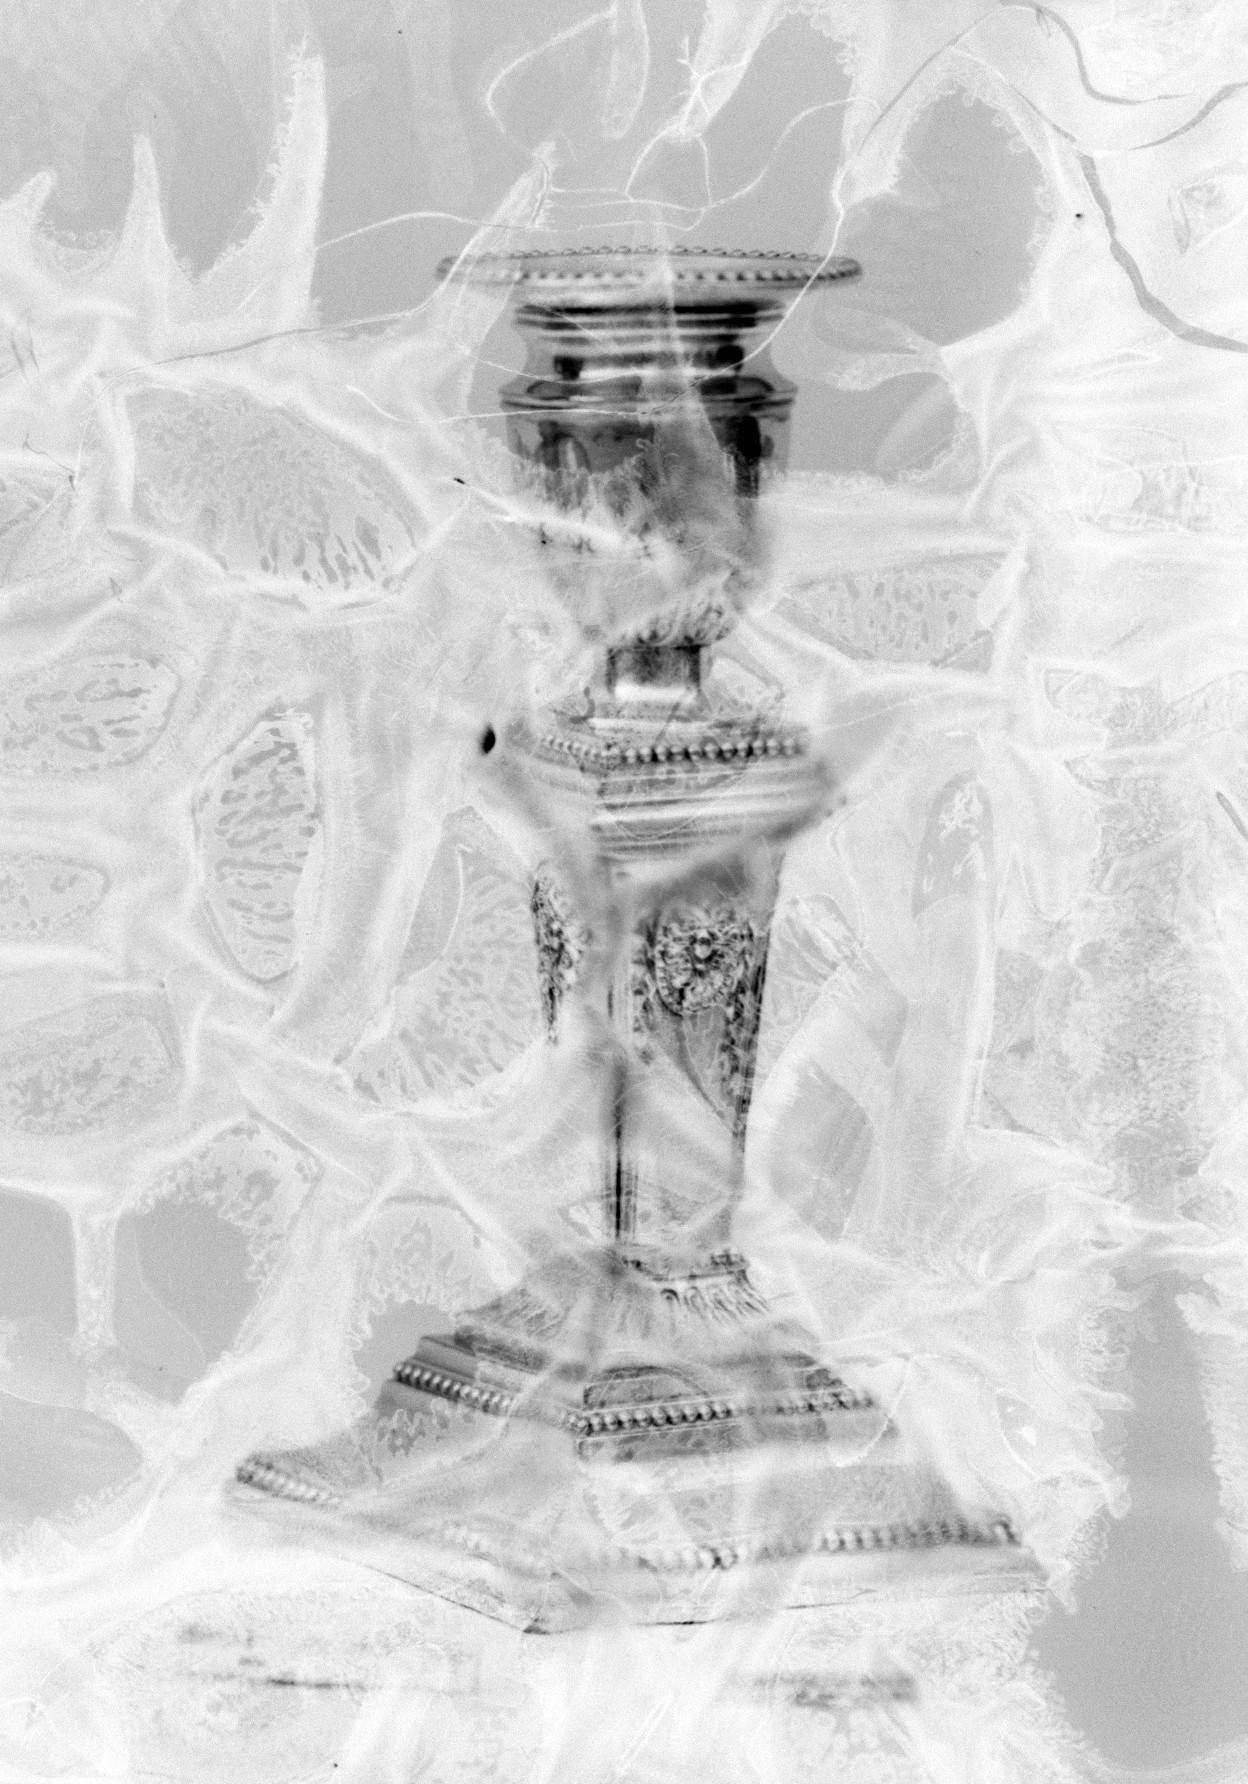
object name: candlestick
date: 1775-1780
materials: metal